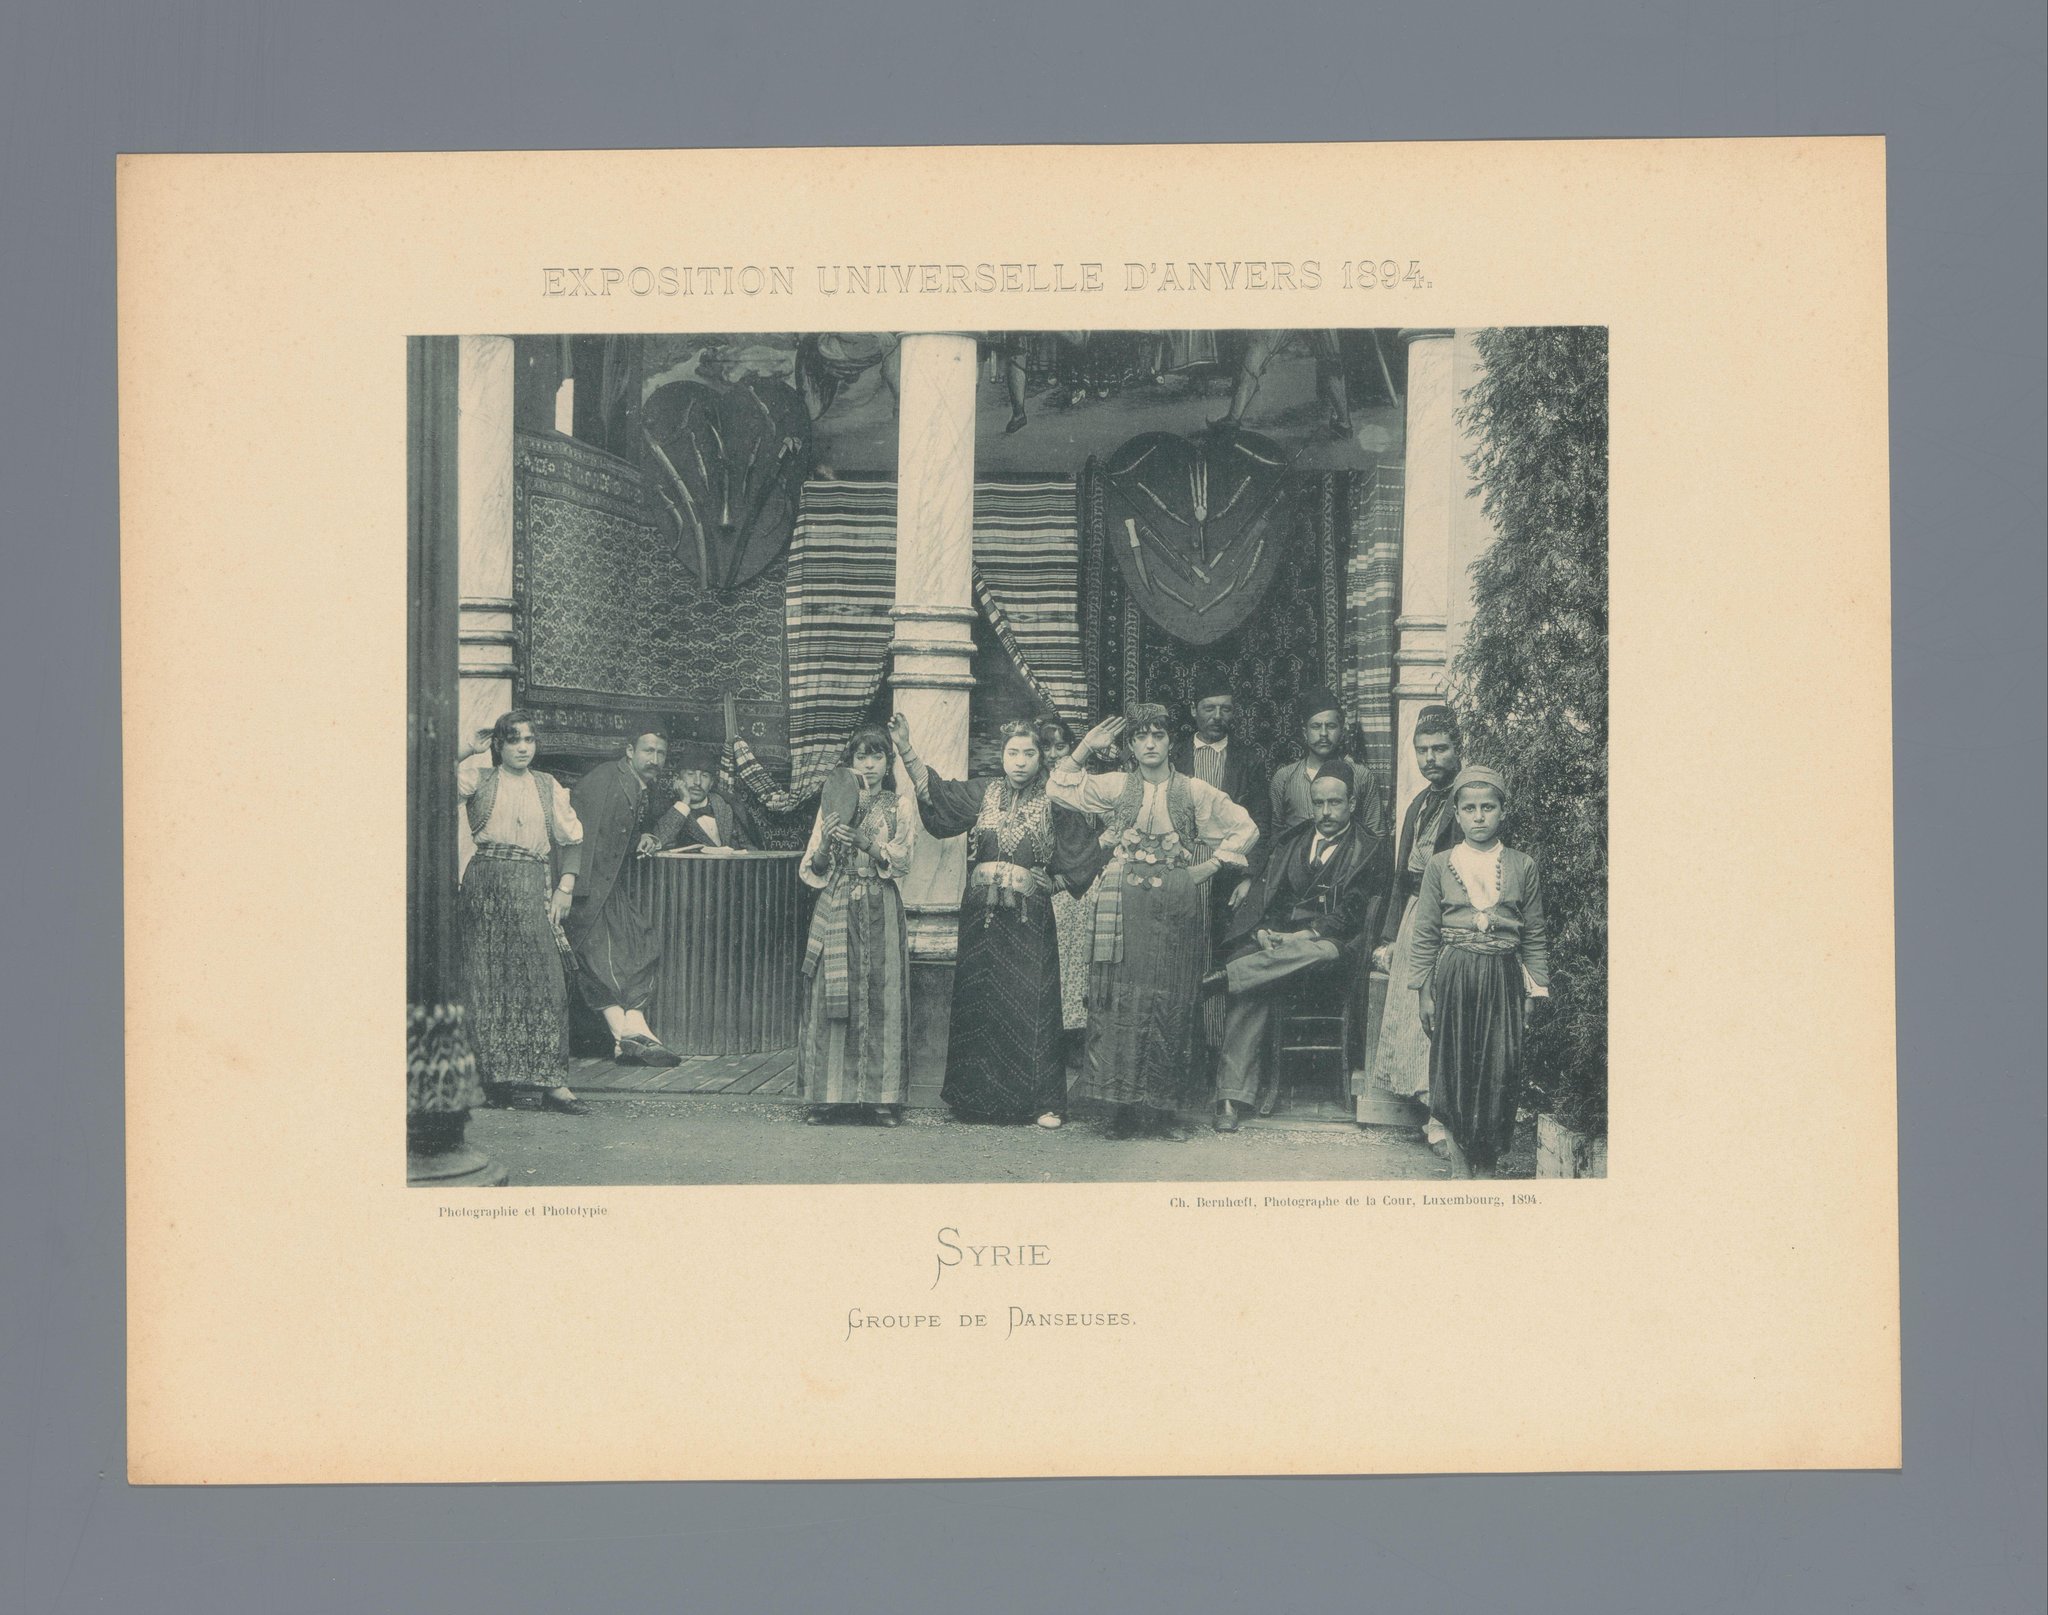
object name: photomechanical print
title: Surie - Groupe de danseurs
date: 1894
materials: paper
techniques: photograph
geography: luxembourg city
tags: world fair, world exhibition, historical persons, asiatic races and peoples (with name), antwerp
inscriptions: inscription: ‘Exposition Universelle D'Anvers 1894’